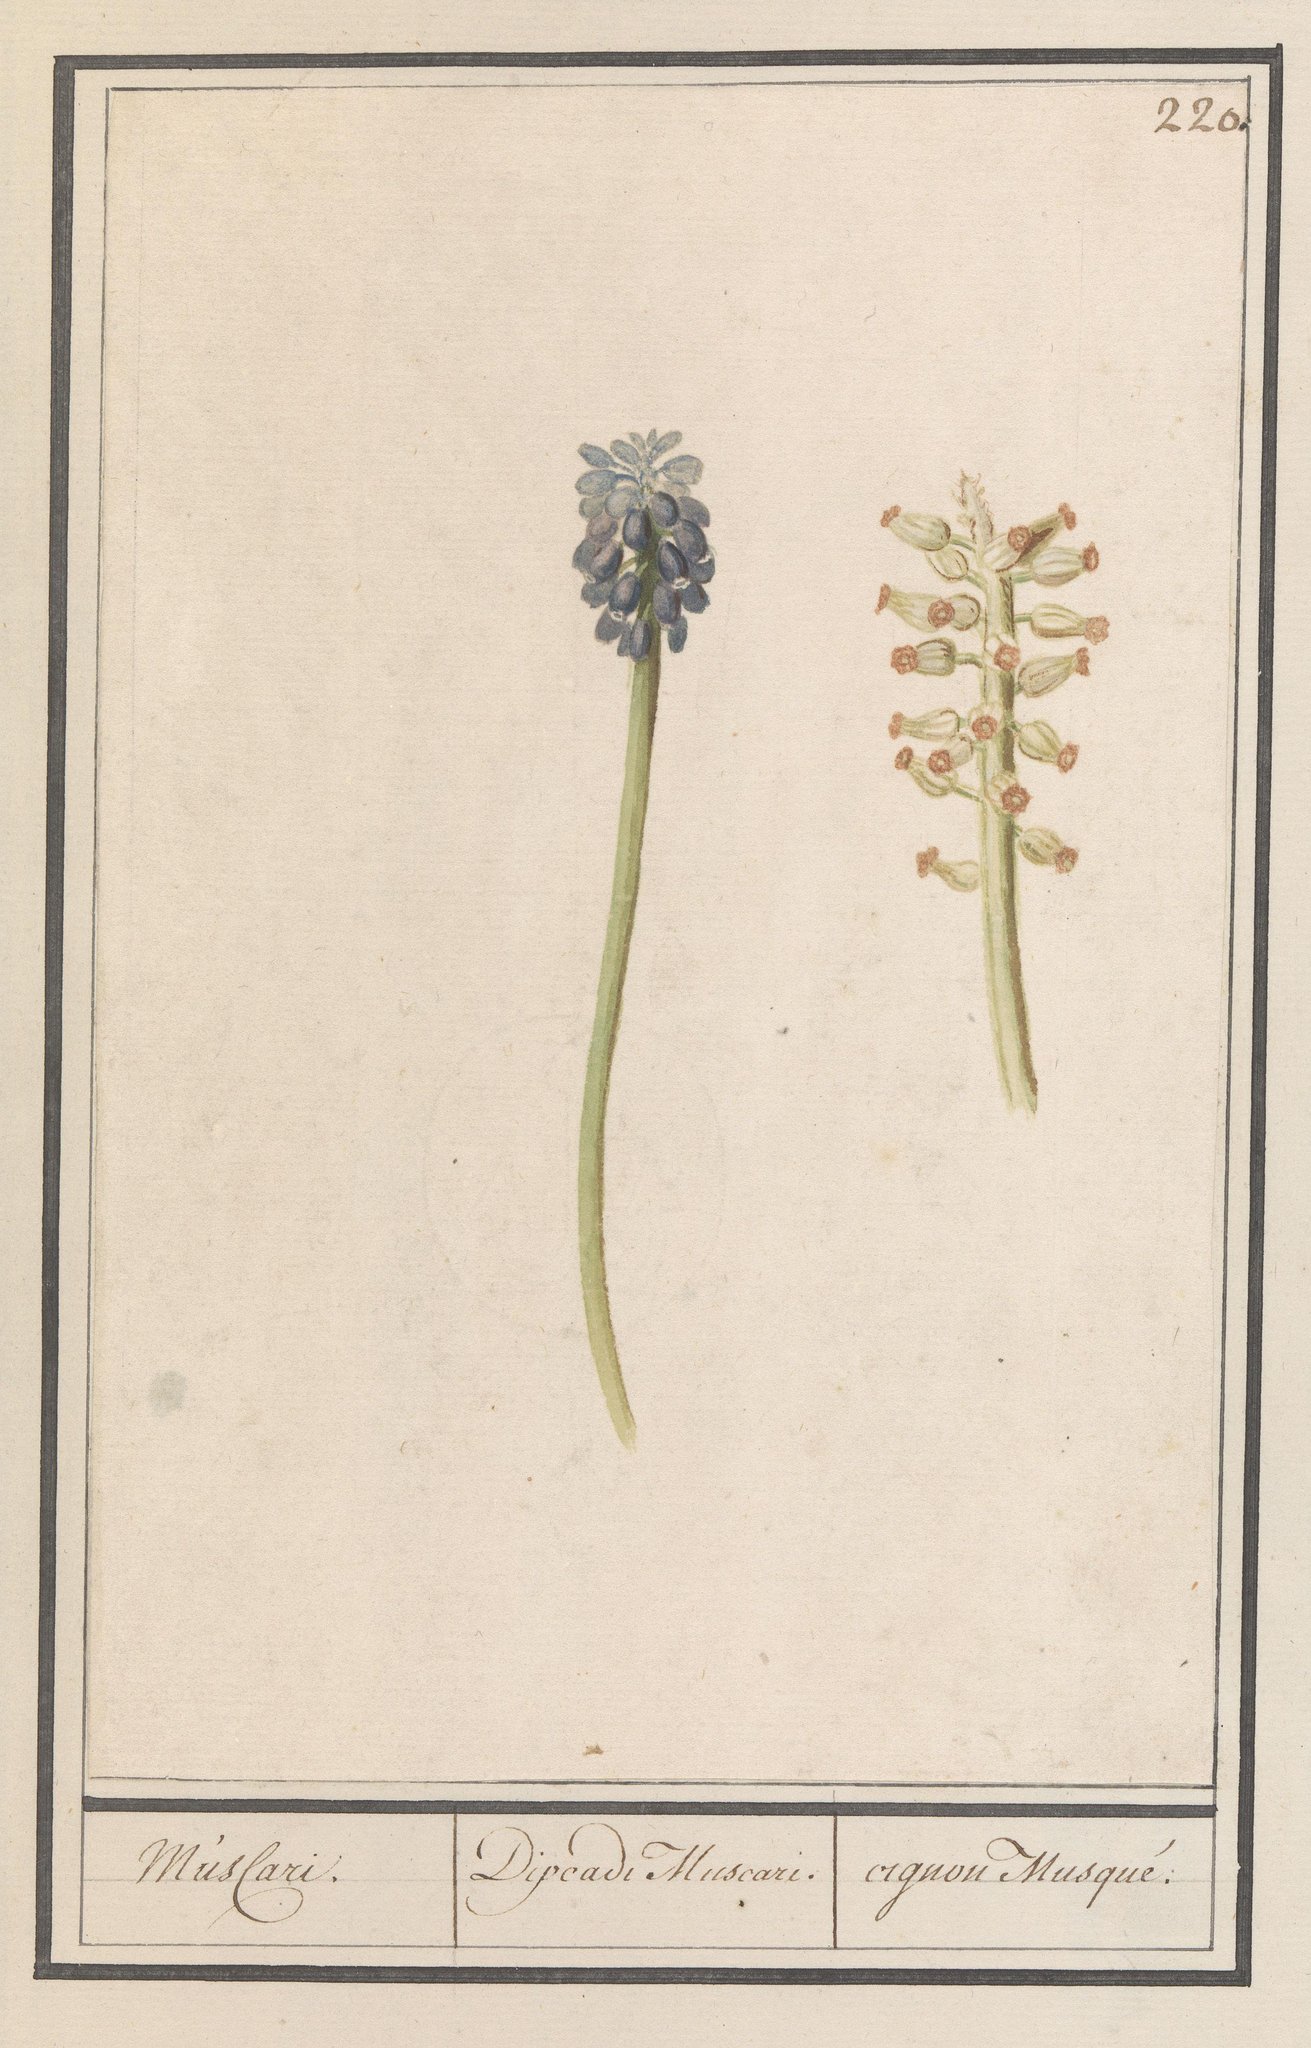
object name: drawing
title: Blauwe druifjes (Muscari botryoides)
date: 1596-1610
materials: chalk, paint, paper, watercolor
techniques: brush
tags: flowers: grape hyacinth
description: Blauwe druifjes. Genummerd rechtsboven: 220. Onderdeel van het derde album met tekeningen van bloemen en planten. Tiende van twaalf albums met tekeningen van dieren, vogels en planten bekend rond 1600, gemaakt in opdracht van keizer Rudolf II. Met toelichting in Nederlands, Latijn en Frans.